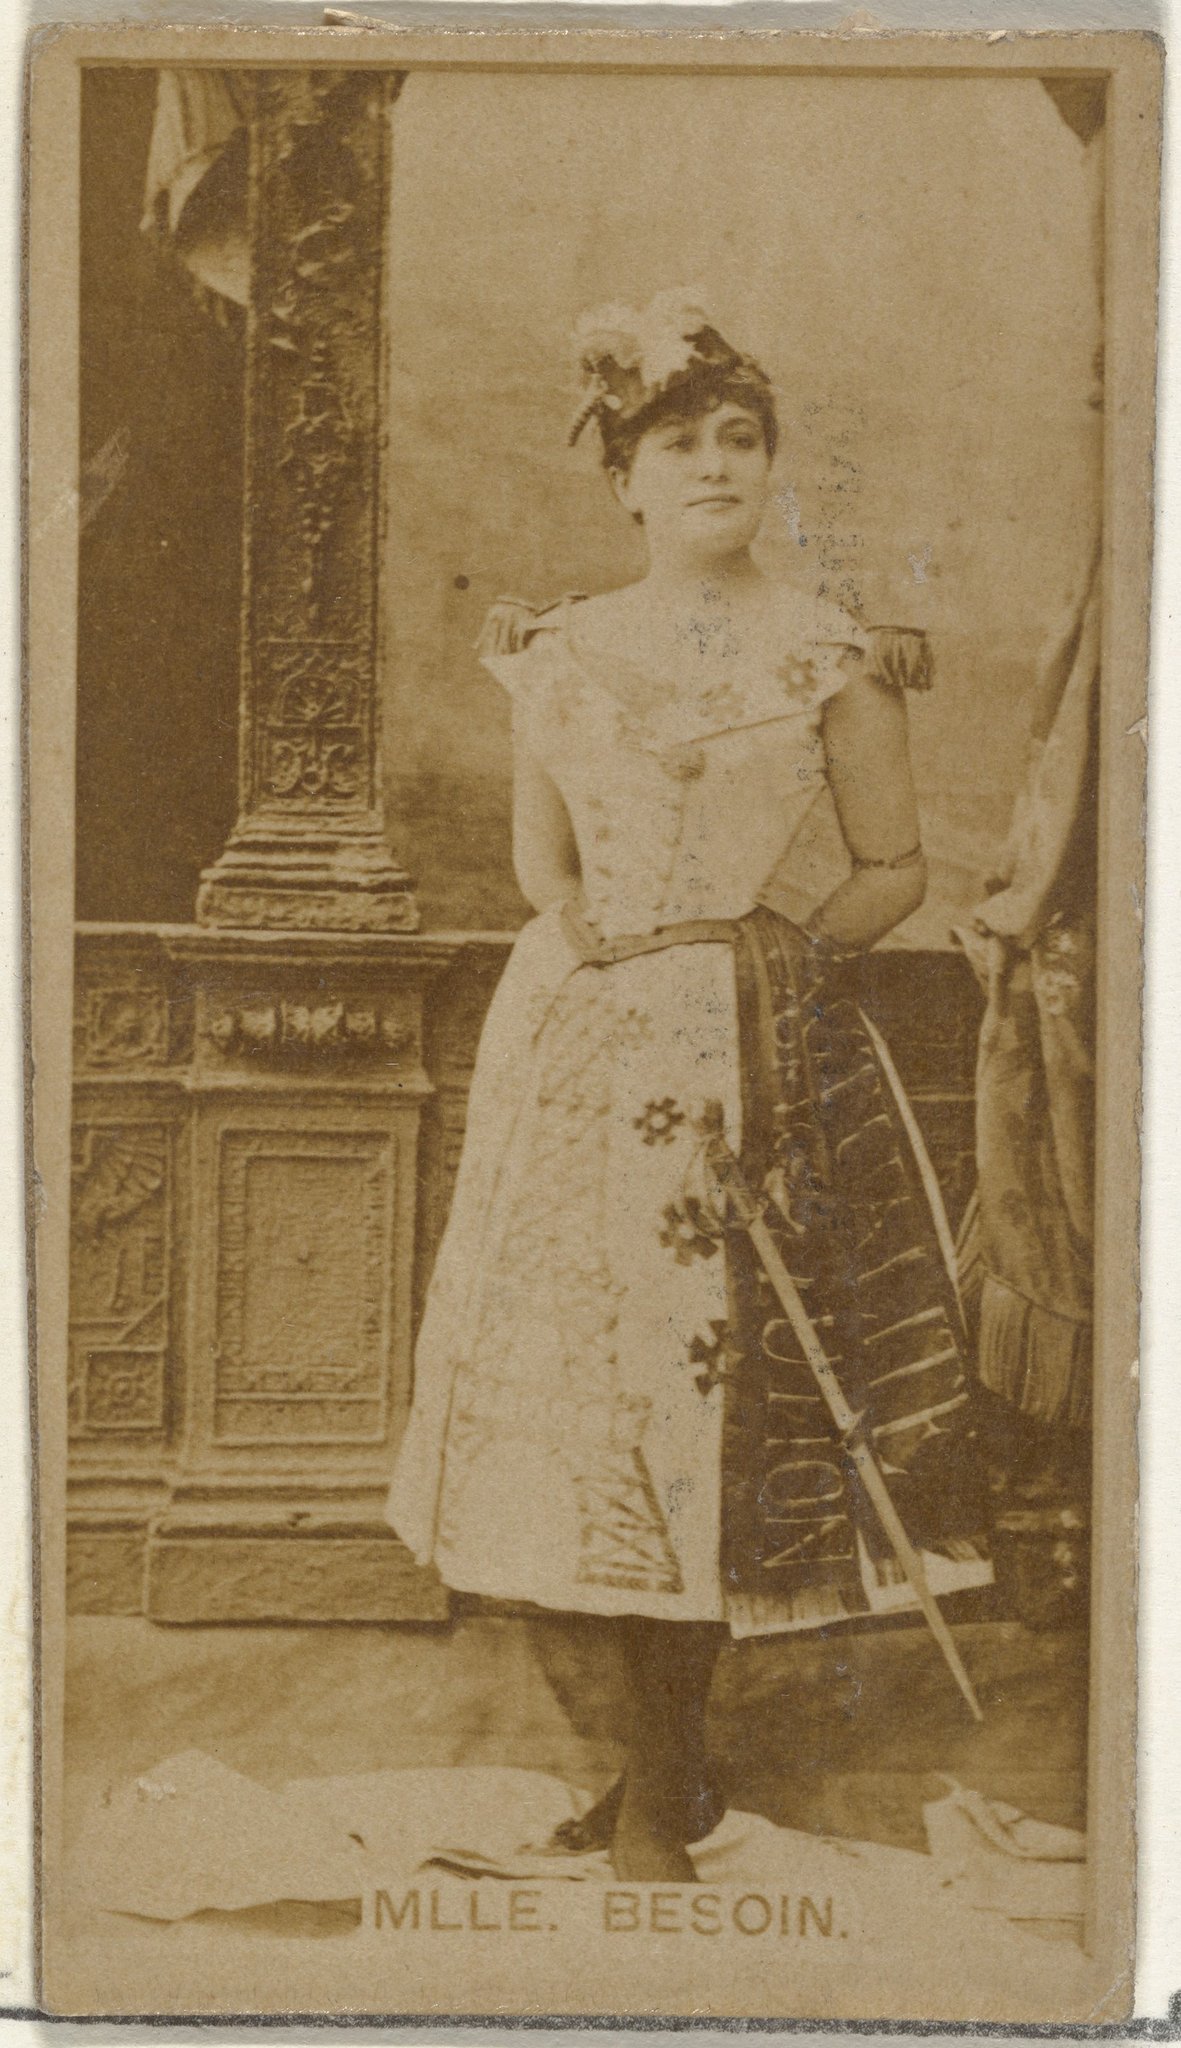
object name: photograph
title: Mlle. Besoin, from the Actors and Actresses series (N145-8) issued by Duke Sons & Co. to promote Duke Cigarettes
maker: w. duke, sons & co.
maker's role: publisher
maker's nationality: american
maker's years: 1870-1920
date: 1891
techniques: albumen silver print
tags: portraits,women,actresses